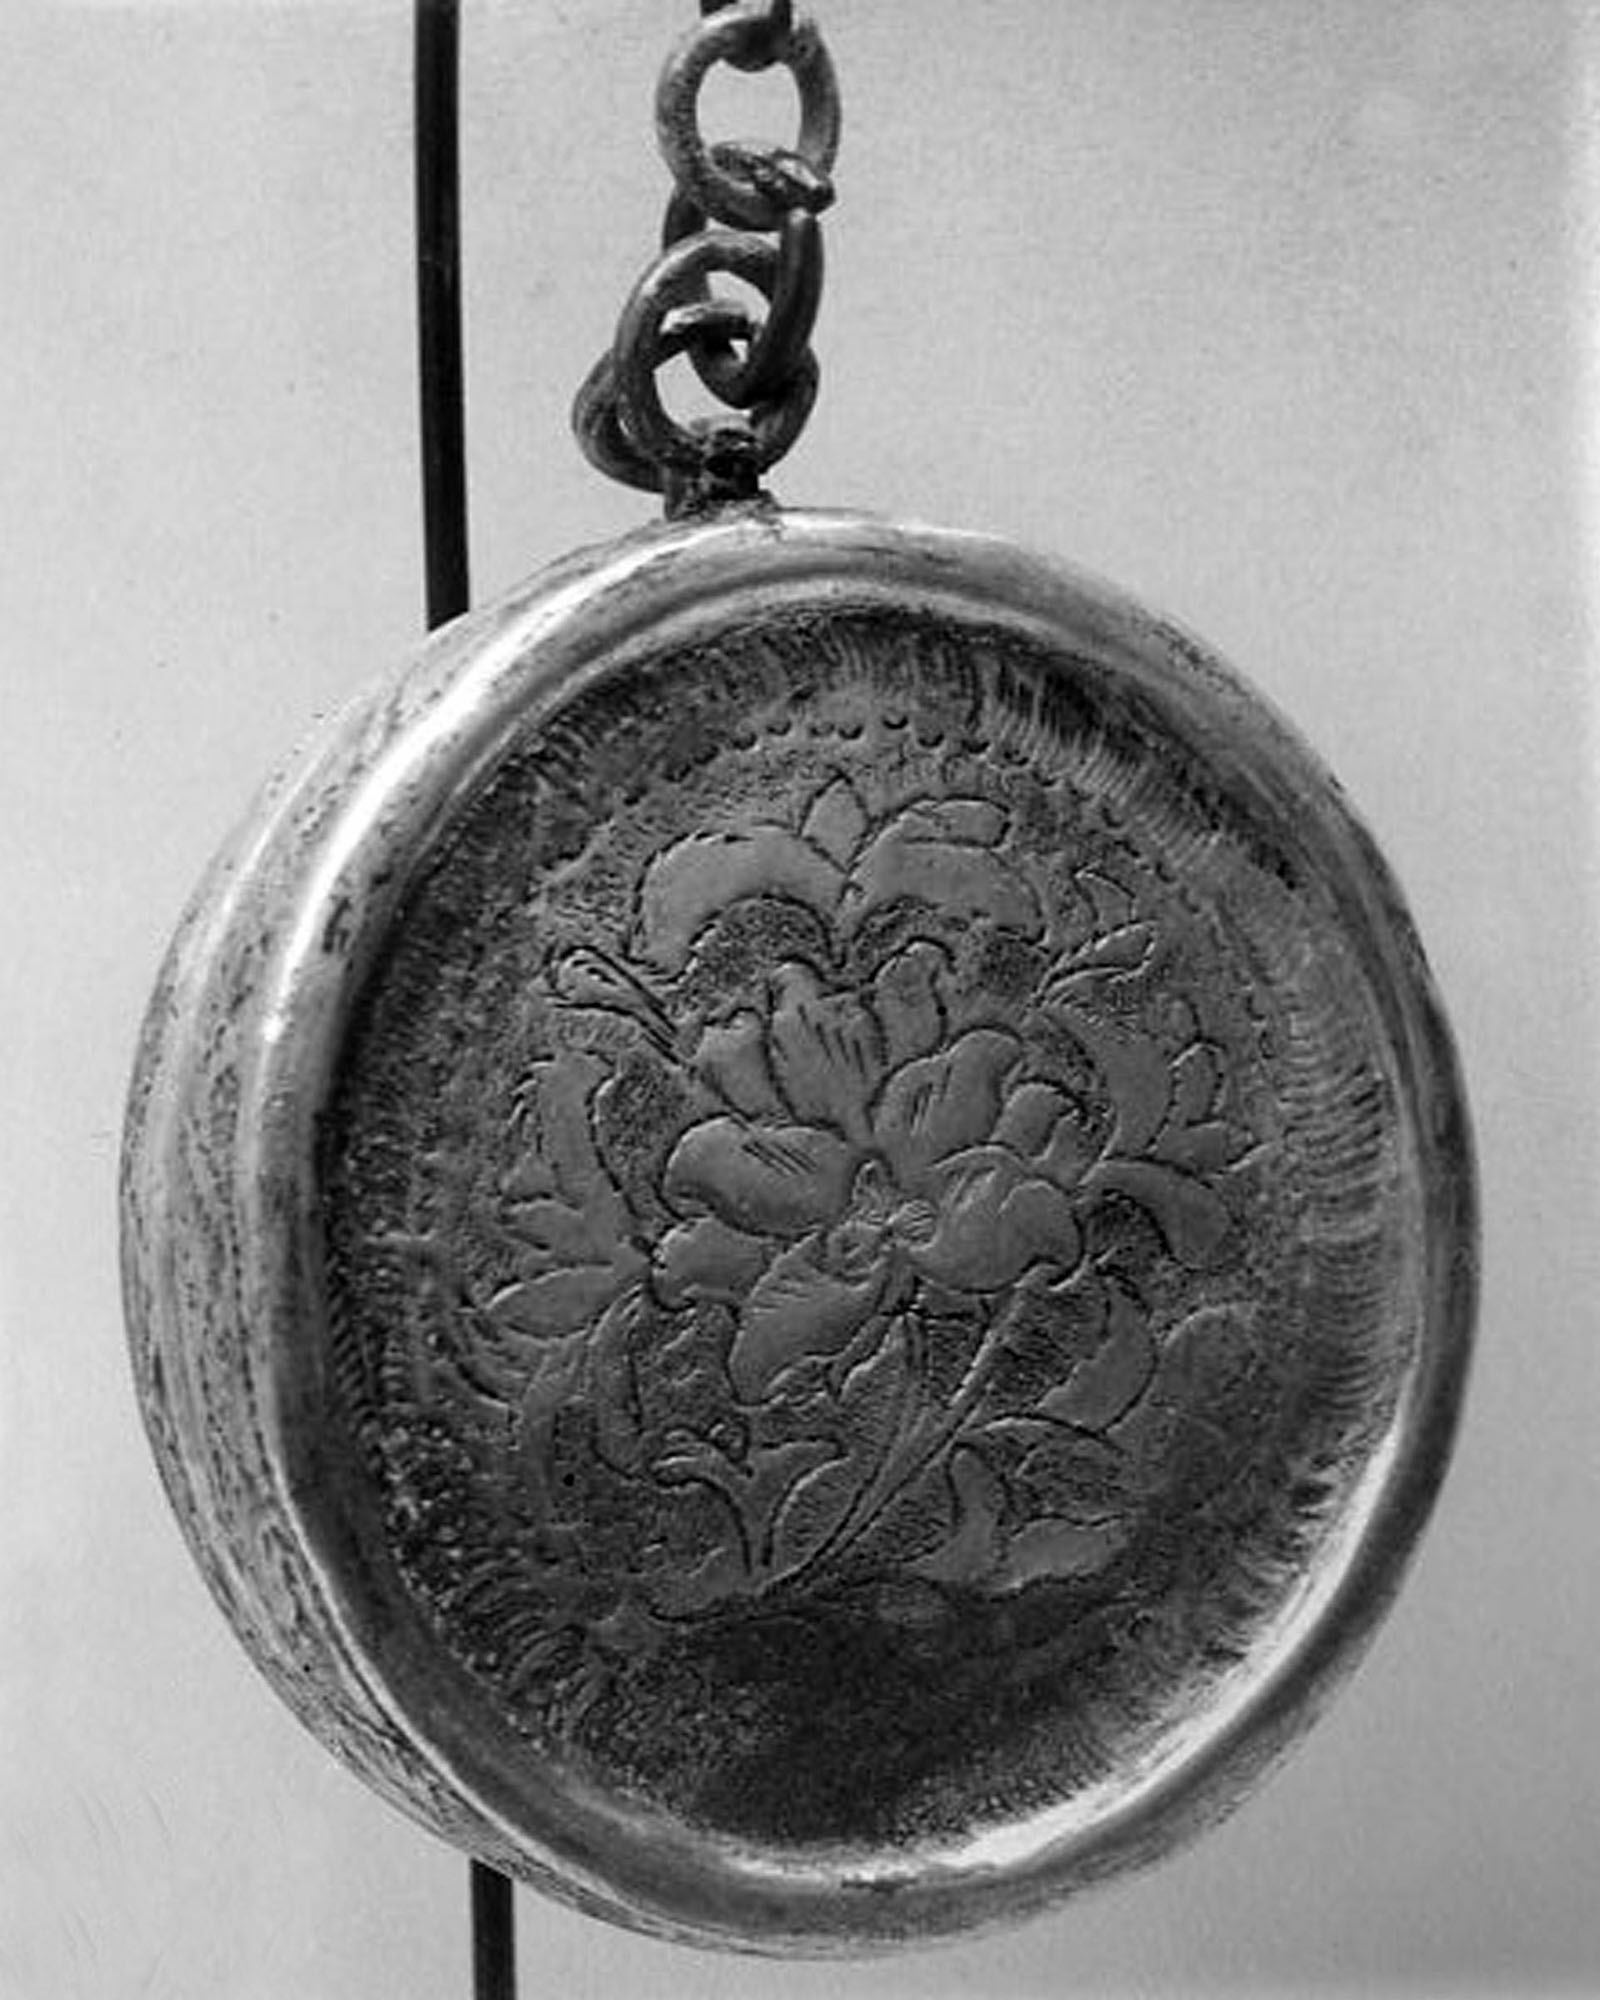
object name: box with chain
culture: chinese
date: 1201-1400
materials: bronze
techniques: gilding